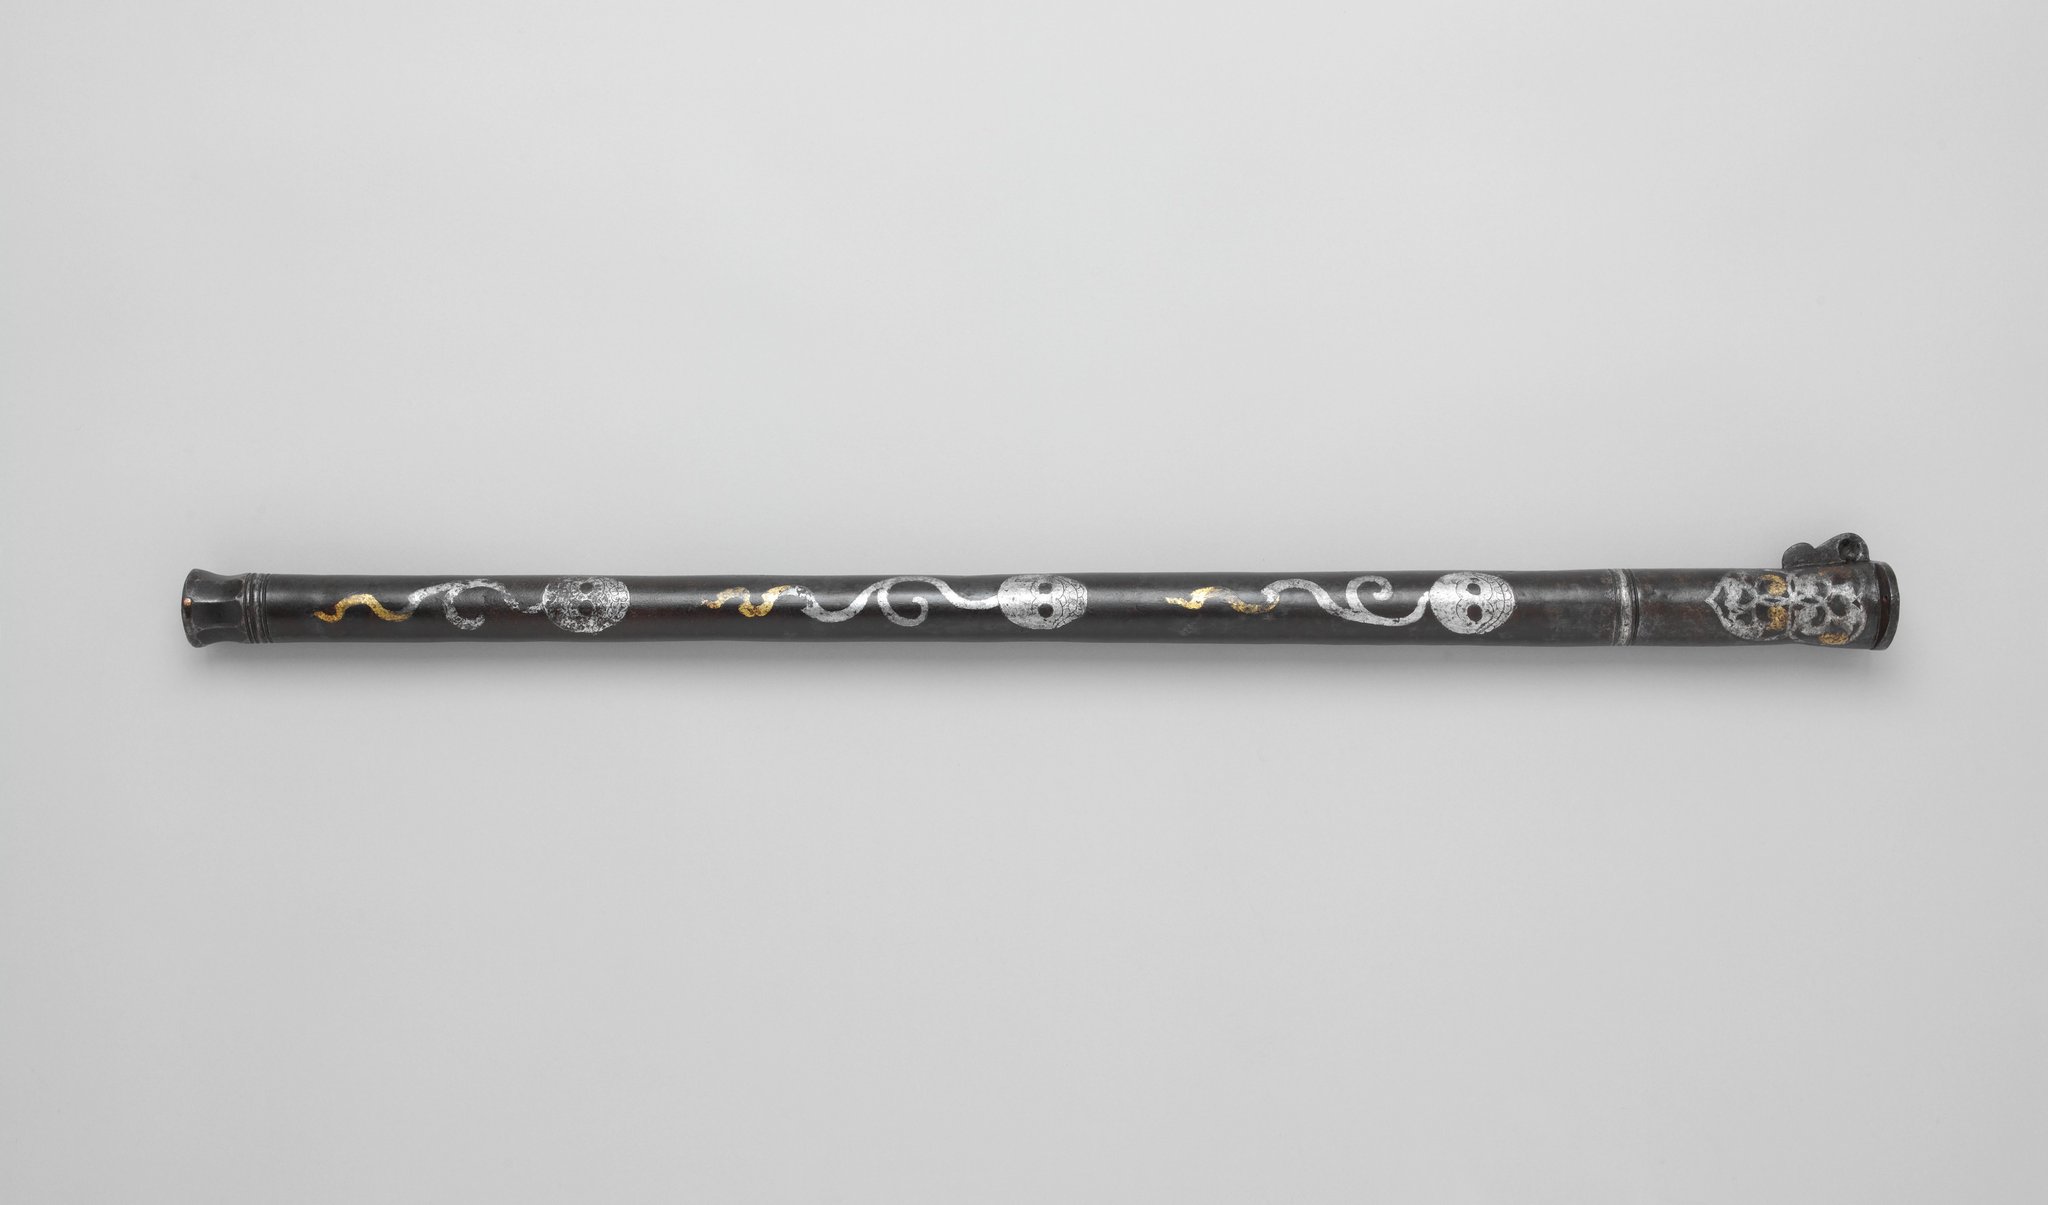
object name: musket barrel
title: Barrel from a Ceremonial Musket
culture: tibetan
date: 1601-1900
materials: copper, gold, iron, silver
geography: tibet